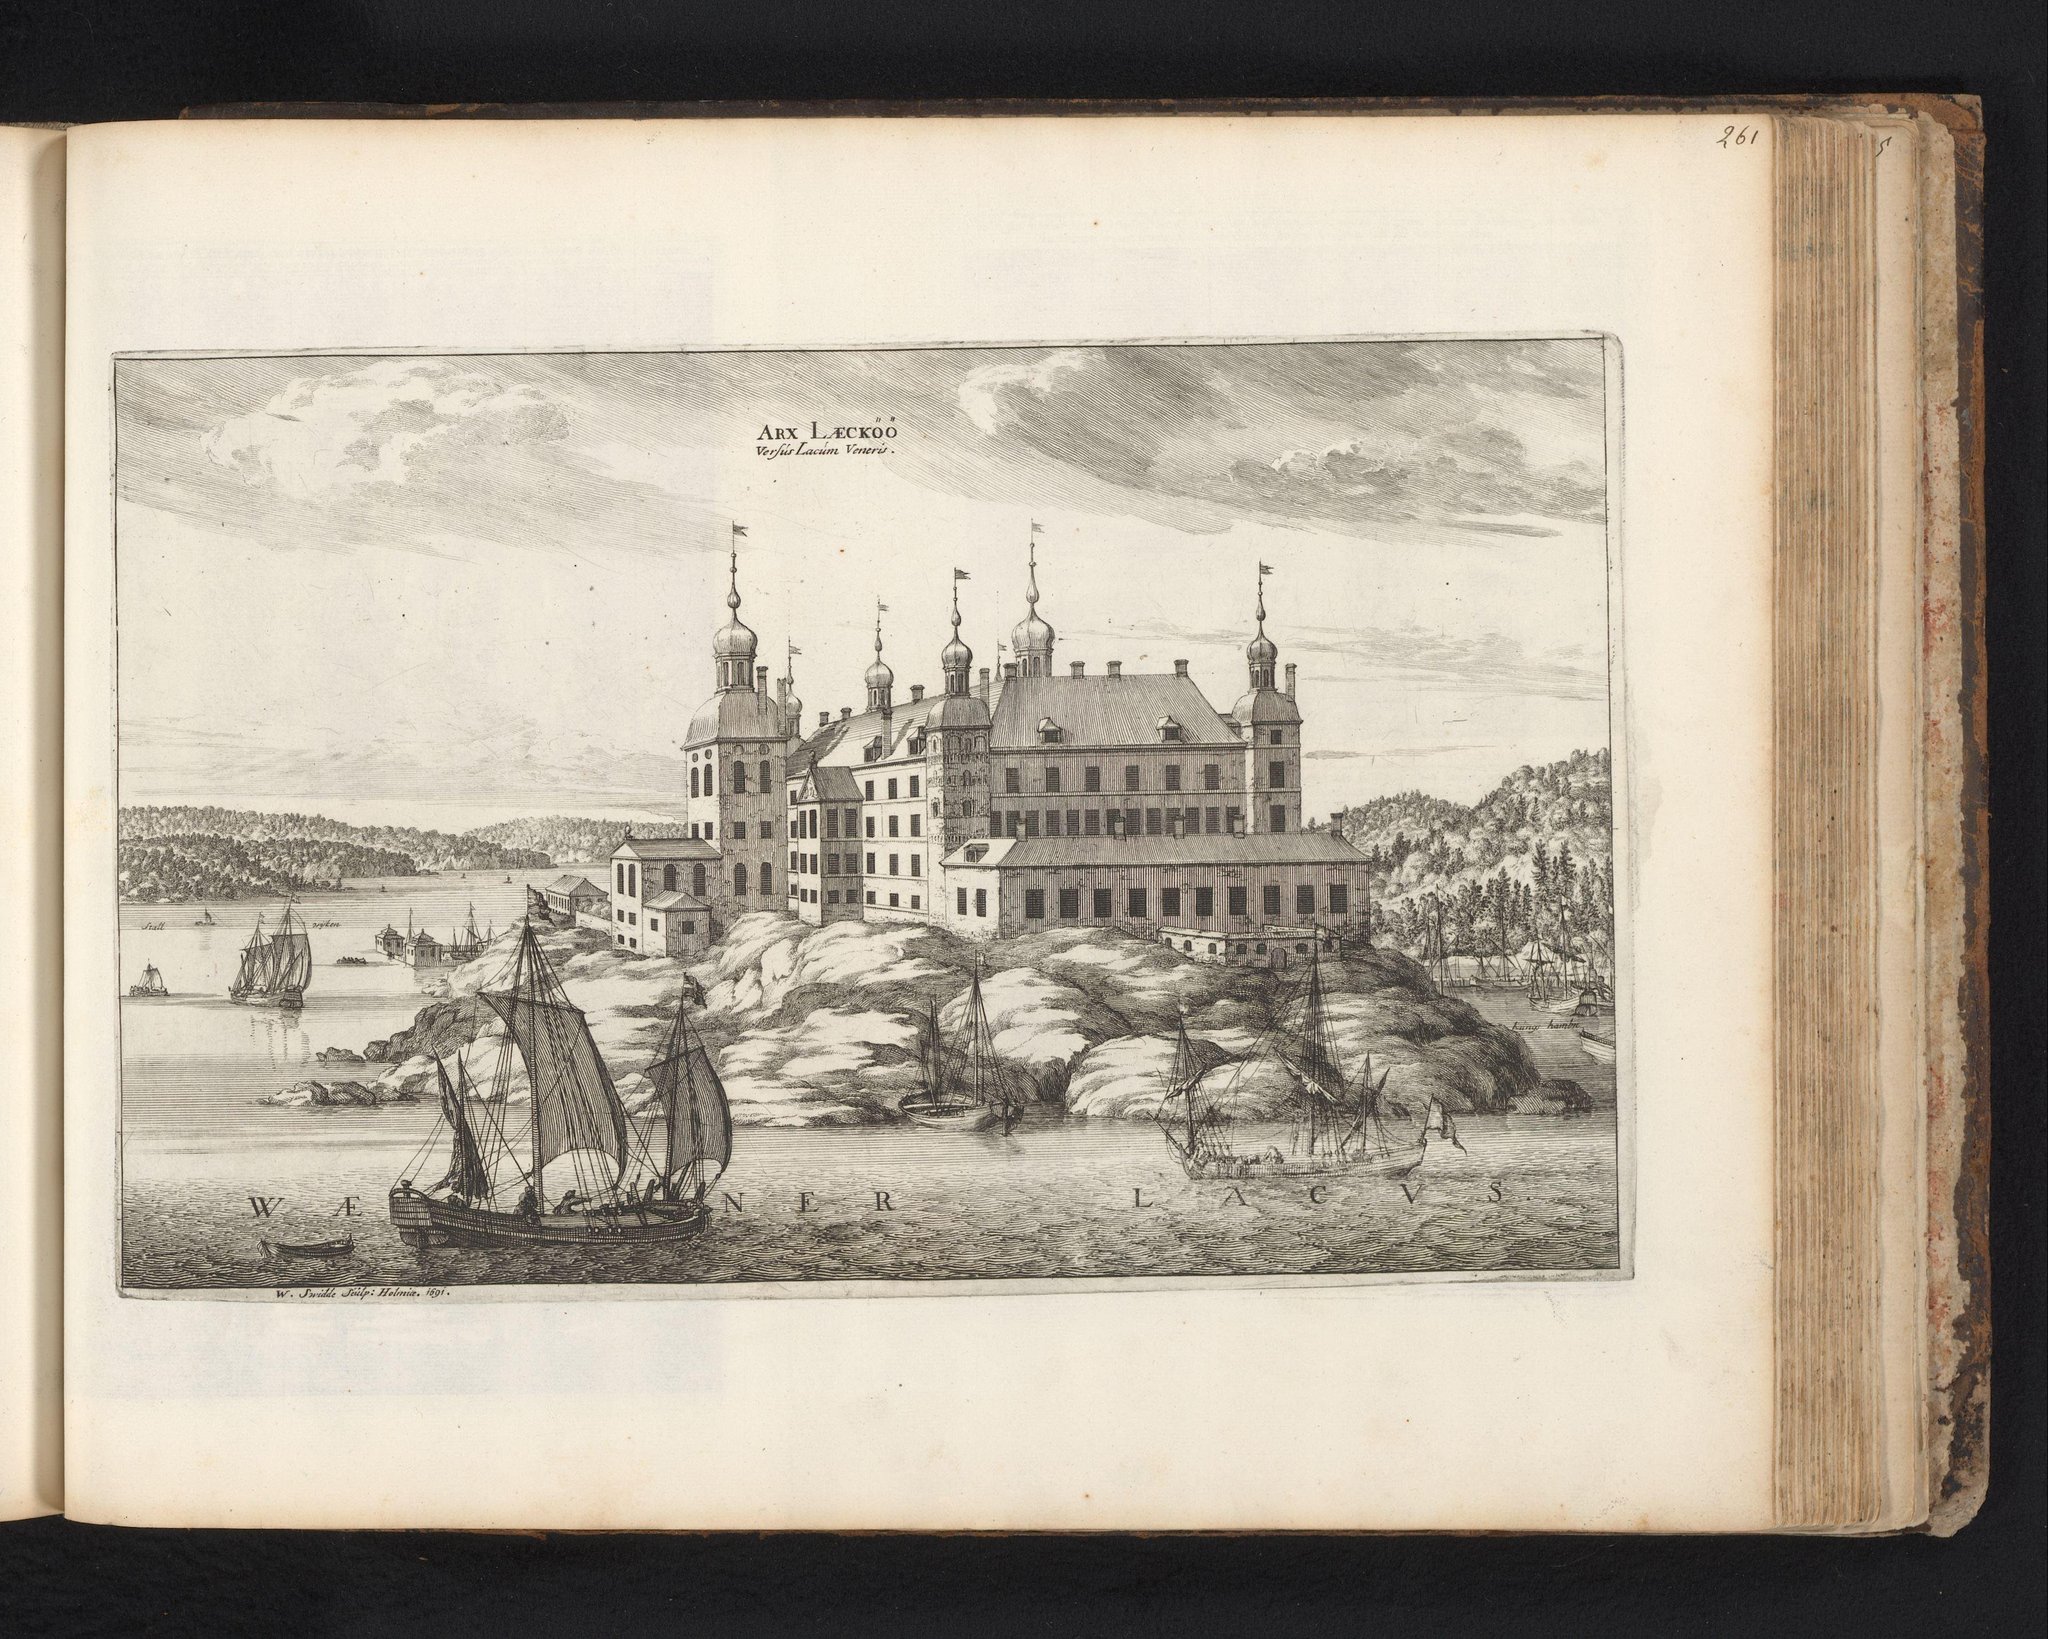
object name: print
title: Gezicht op slot Läckö, vanuit het Vänermeer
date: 1691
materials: paper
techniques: etching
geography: stockholm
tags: castle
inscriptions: date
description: Kungliga Biblioteket, 'Suecia': http://www.kb.se/samlingarna/Kartor-bilder/Suecia-antiqua/ (geraadpleegd november 2016).